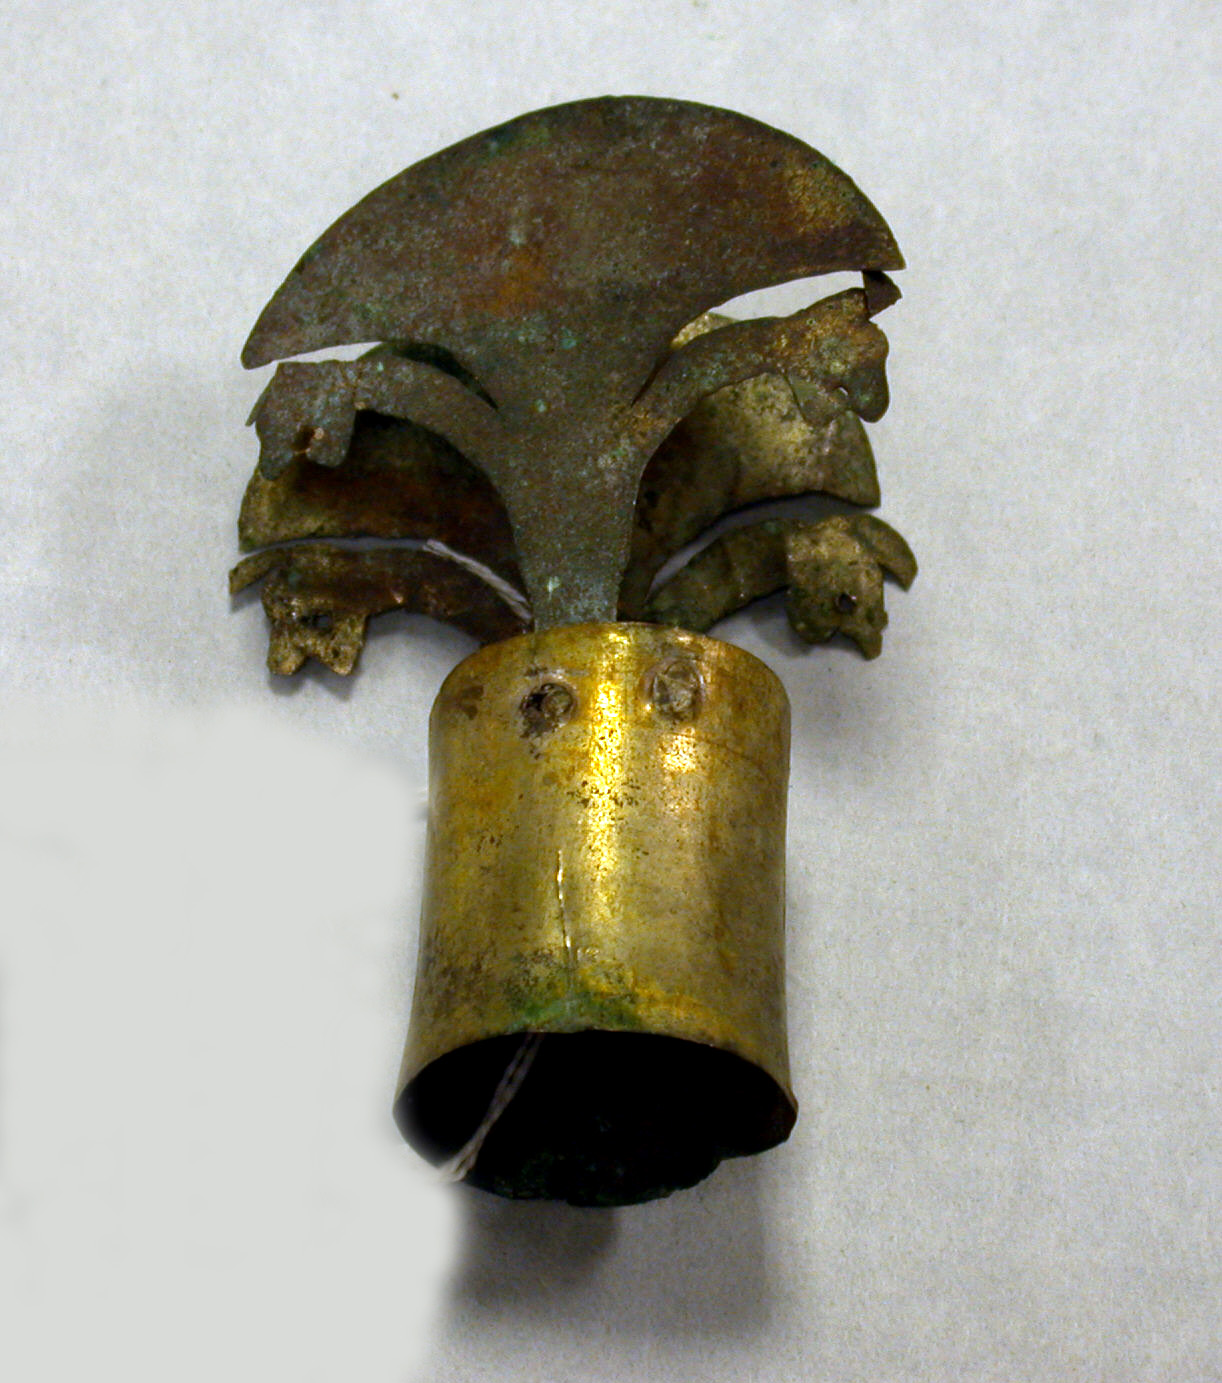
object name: crown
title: Hammered Silver Miniature Crown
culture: peruvian, north or central coast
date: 1001-1566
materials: gilt, silver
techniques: hammering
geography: peru